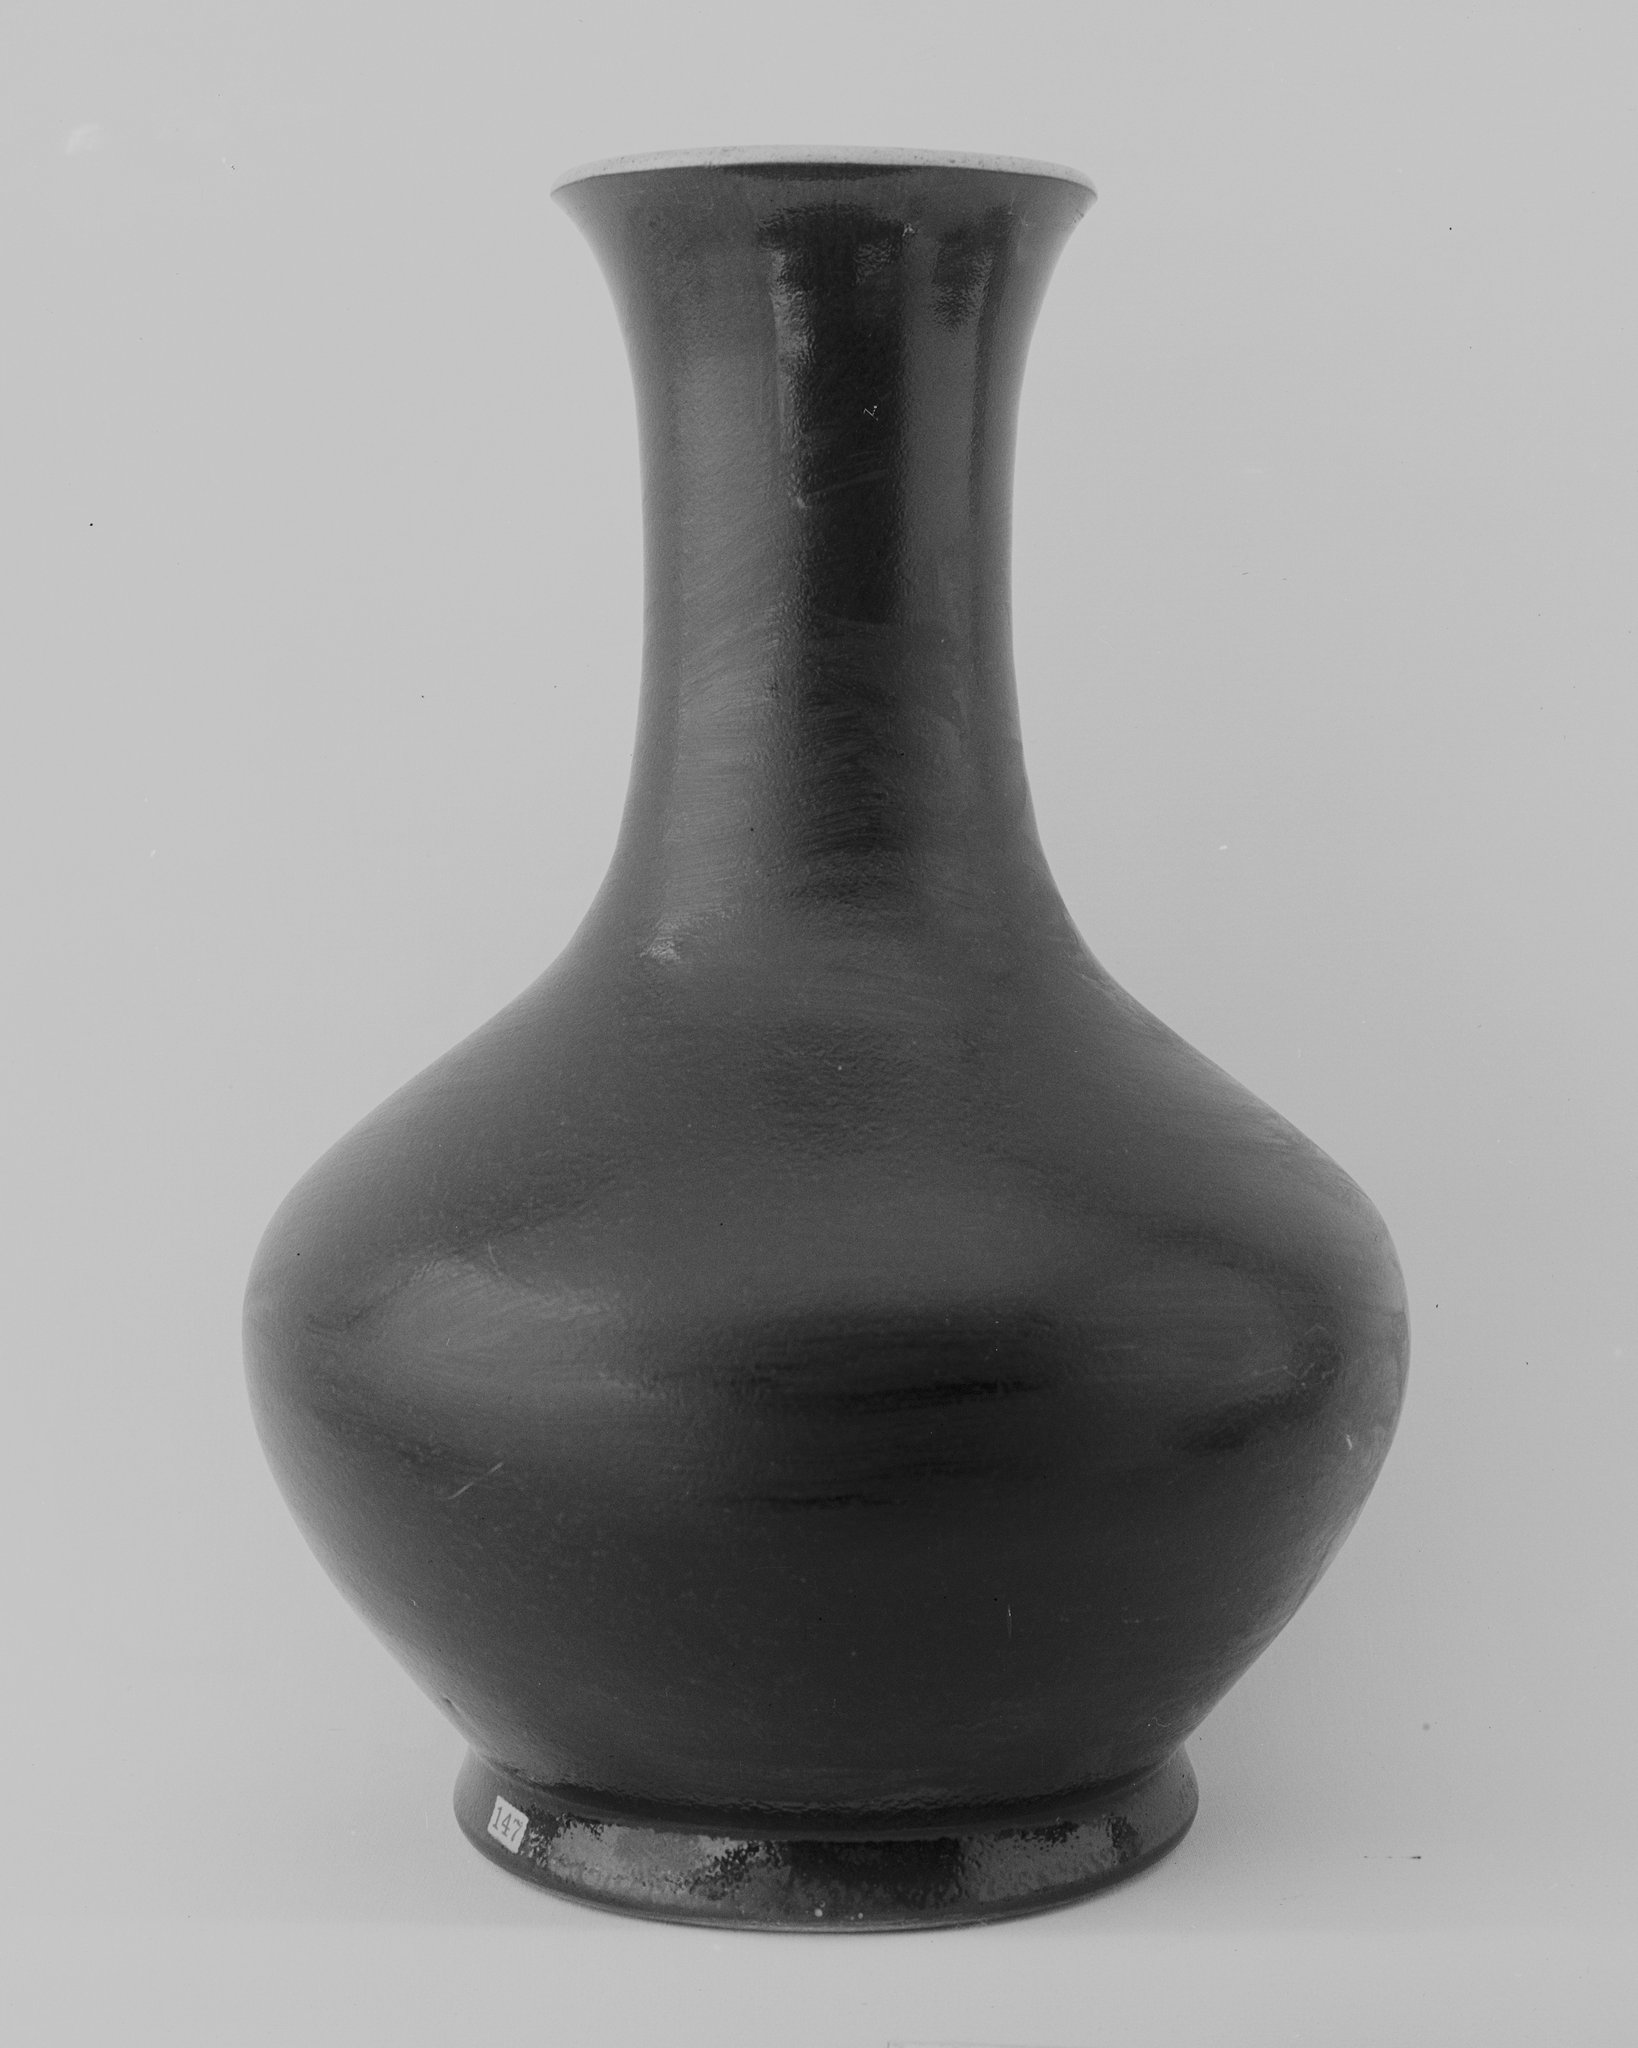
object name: vase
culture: chinese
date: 1801-1850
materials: glaze, porcelain